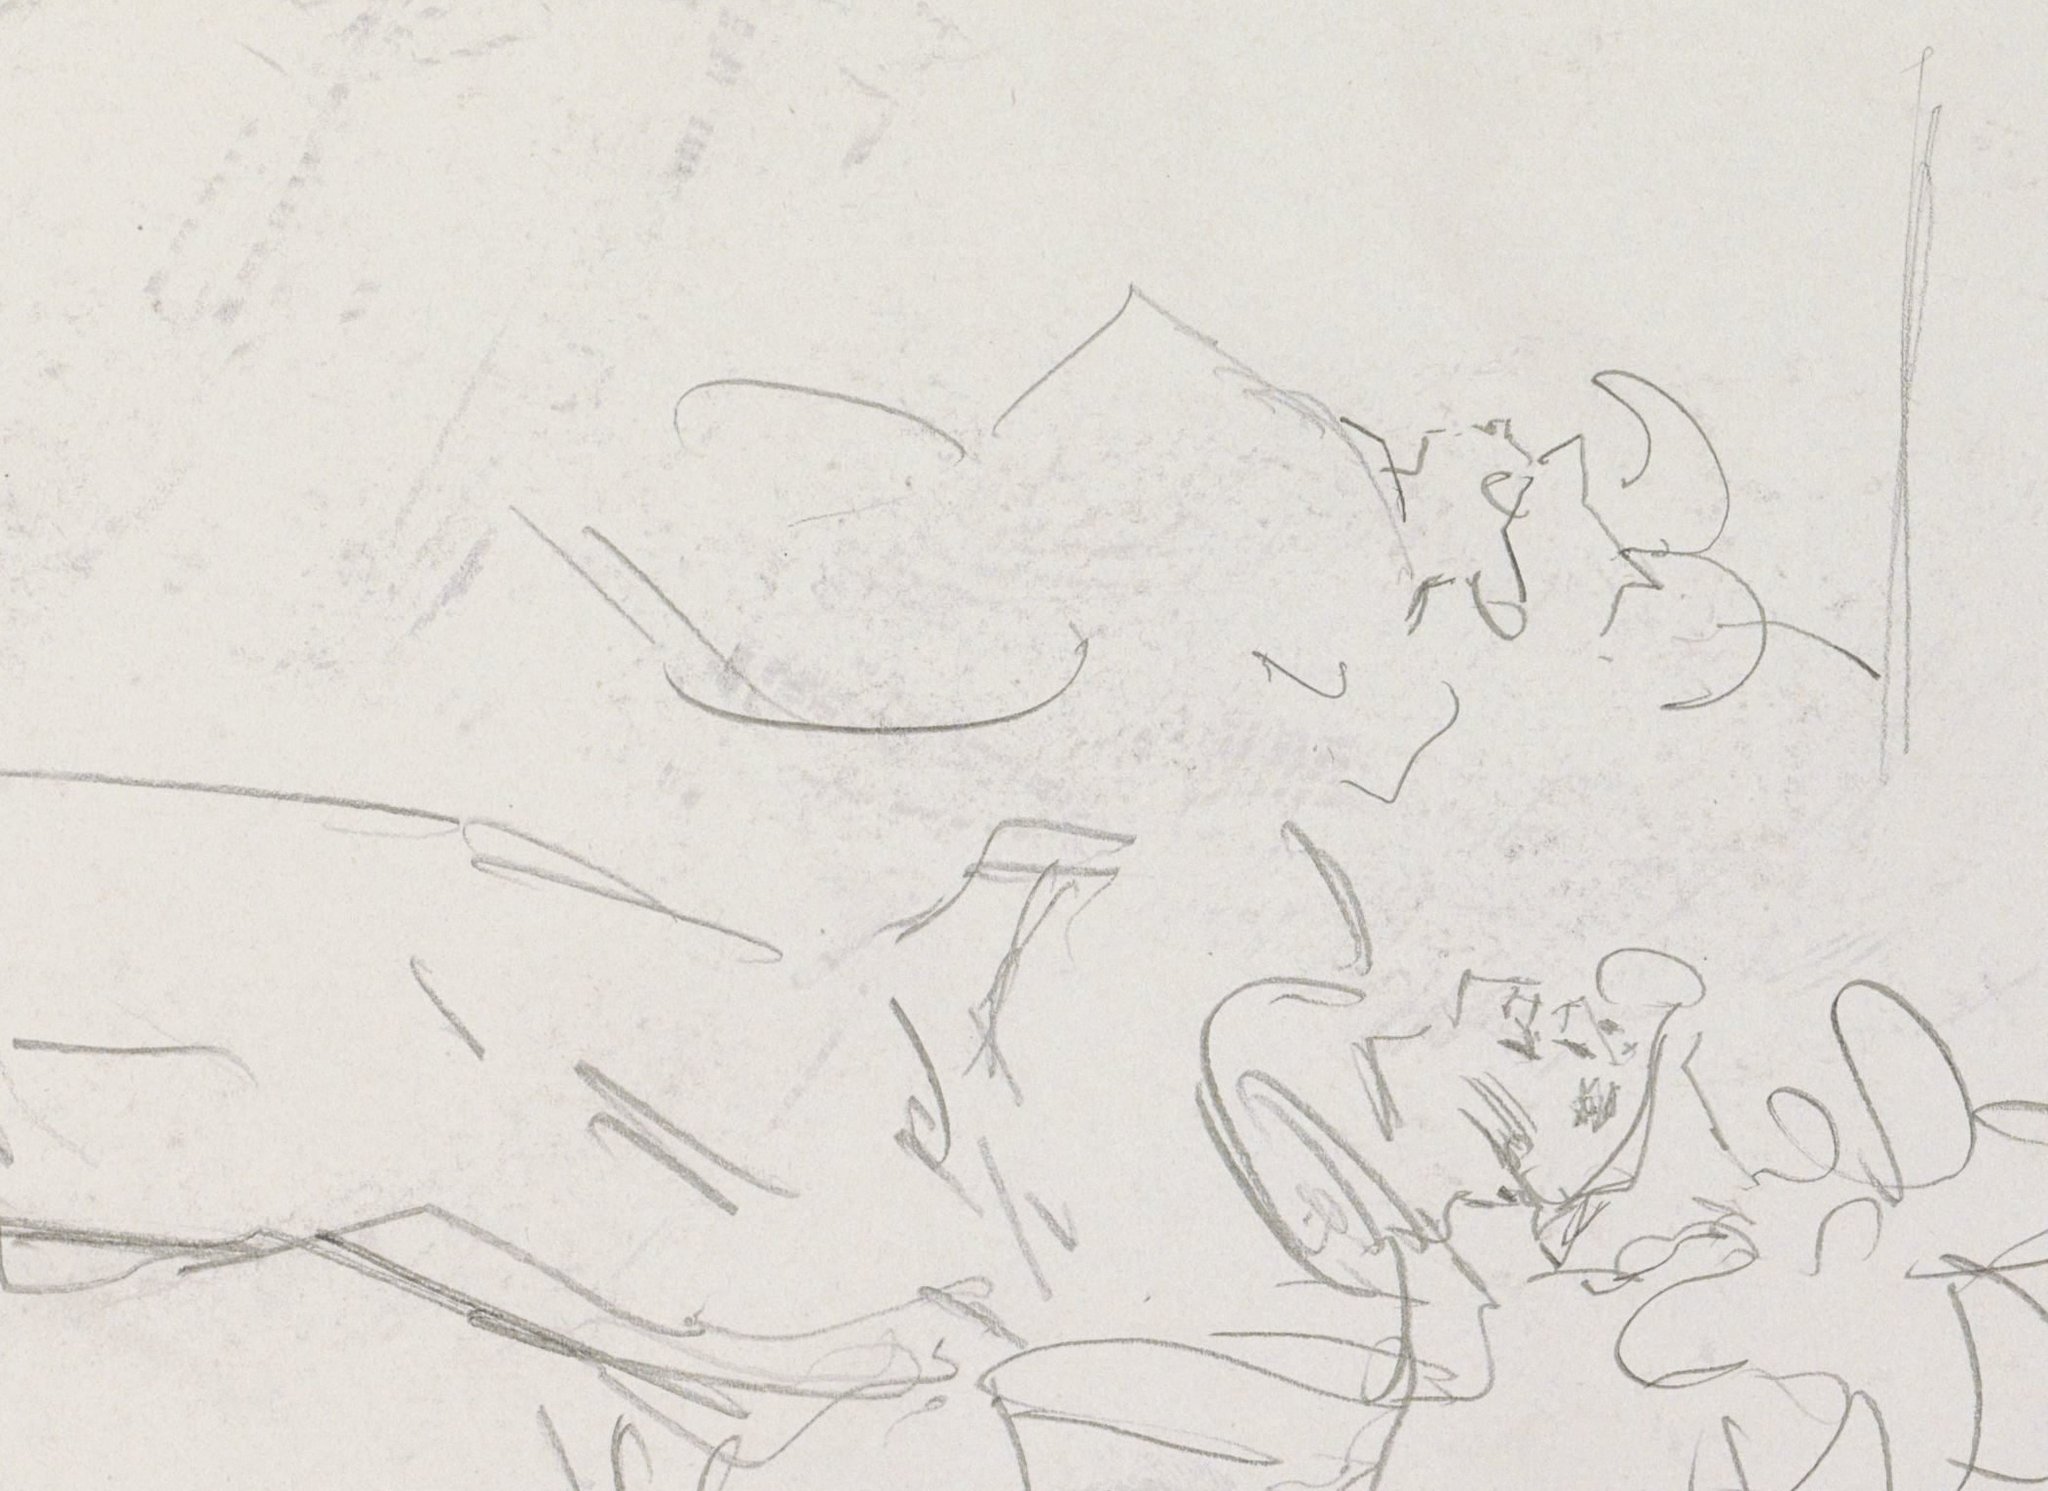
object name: endleaf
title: Danseres, mogelijk voor een spiegel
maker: isaac israels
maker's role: draughtsman, painter, print maker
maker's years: 1865-1934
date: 1915-1934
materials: paper, pencil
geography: the hague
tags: female dancer, reflection (in a mirror)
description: Schutblad A, voorste schutblad, uit schetsboek III met 36 bladen.